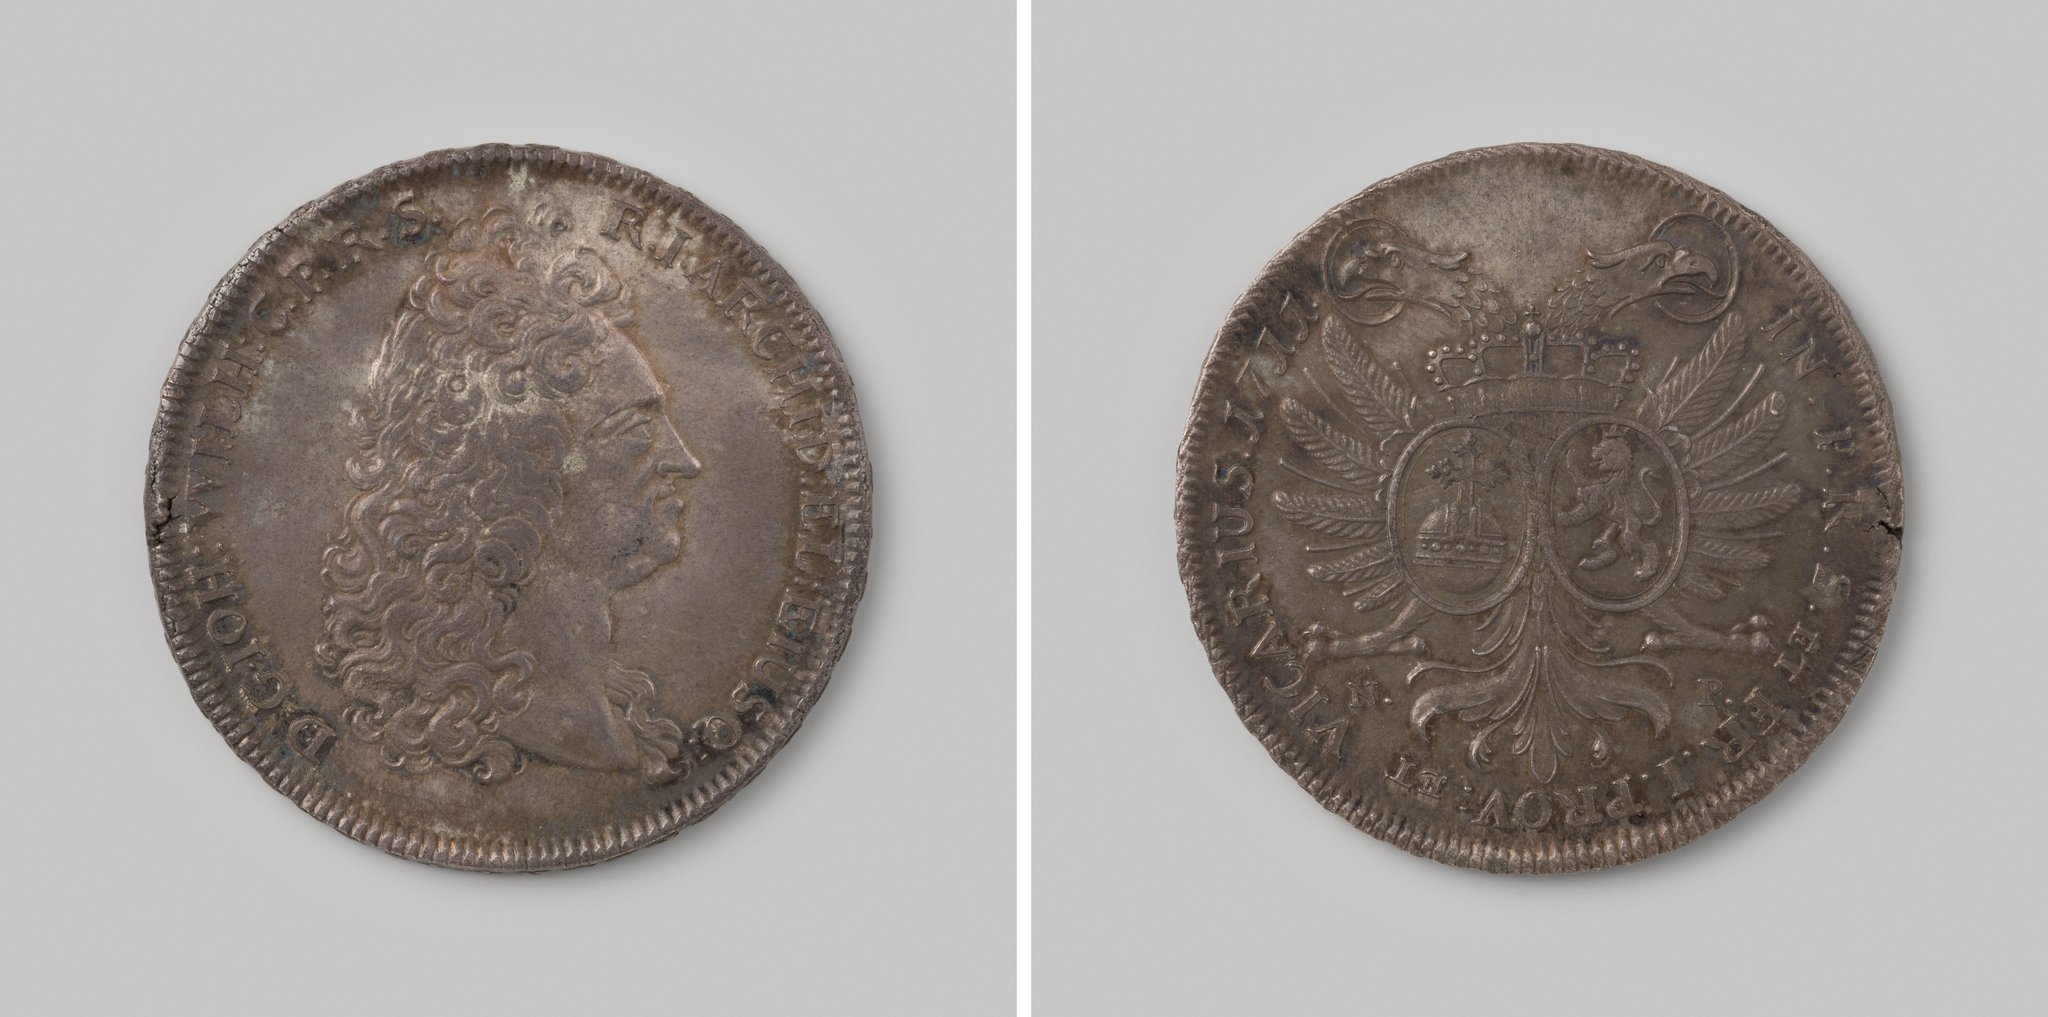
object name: taler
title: Taler uit Churpfalz op de voet van de Bourgondische rijksdaalder van Johann Wilhelm von Neuburg, 1711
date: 1711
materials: silver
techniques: striking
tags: düsseldorf, hertog, keurvorst, johann wilhelm von der pfalz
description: Zilveren munt. Voorzijde: hoofd van de vorst naar rechts. Keerzijde: dubbelkoppige adelaar met twee ovale wapenschilden, waarboven één kroon op de borst.Jaartal aan het eind van het omschrift. Randschrift: NACH BURGUNDISCHEN FUES.